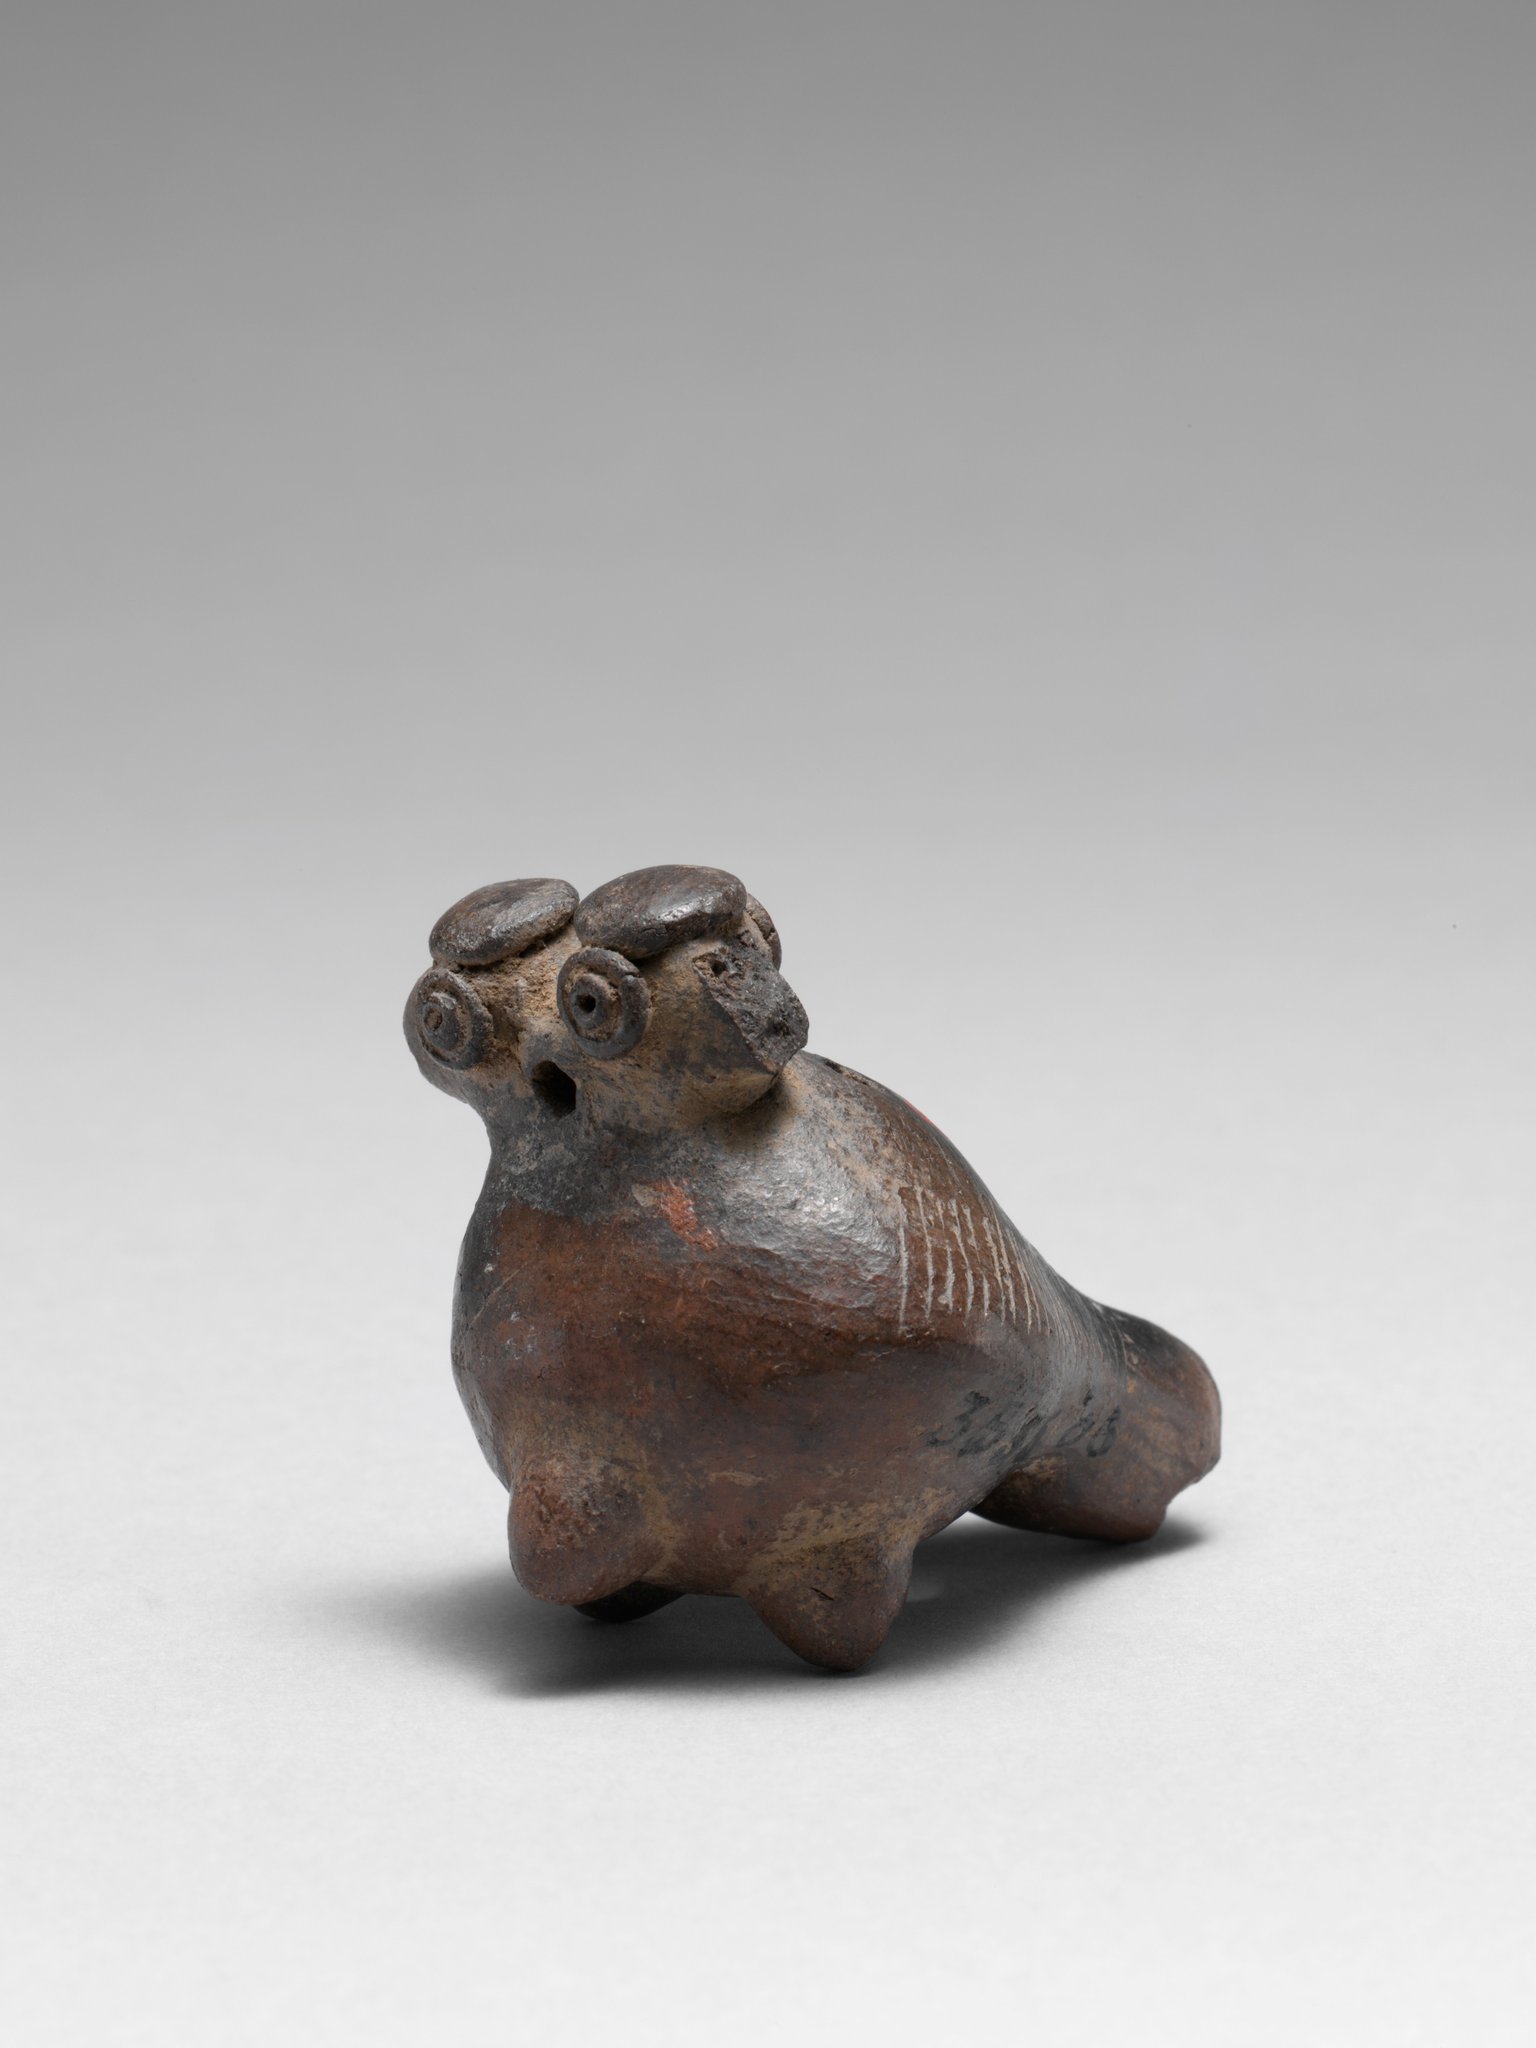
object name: pottery whistle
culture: costa rican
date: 800-1525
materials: clay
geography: costa rica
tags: birds